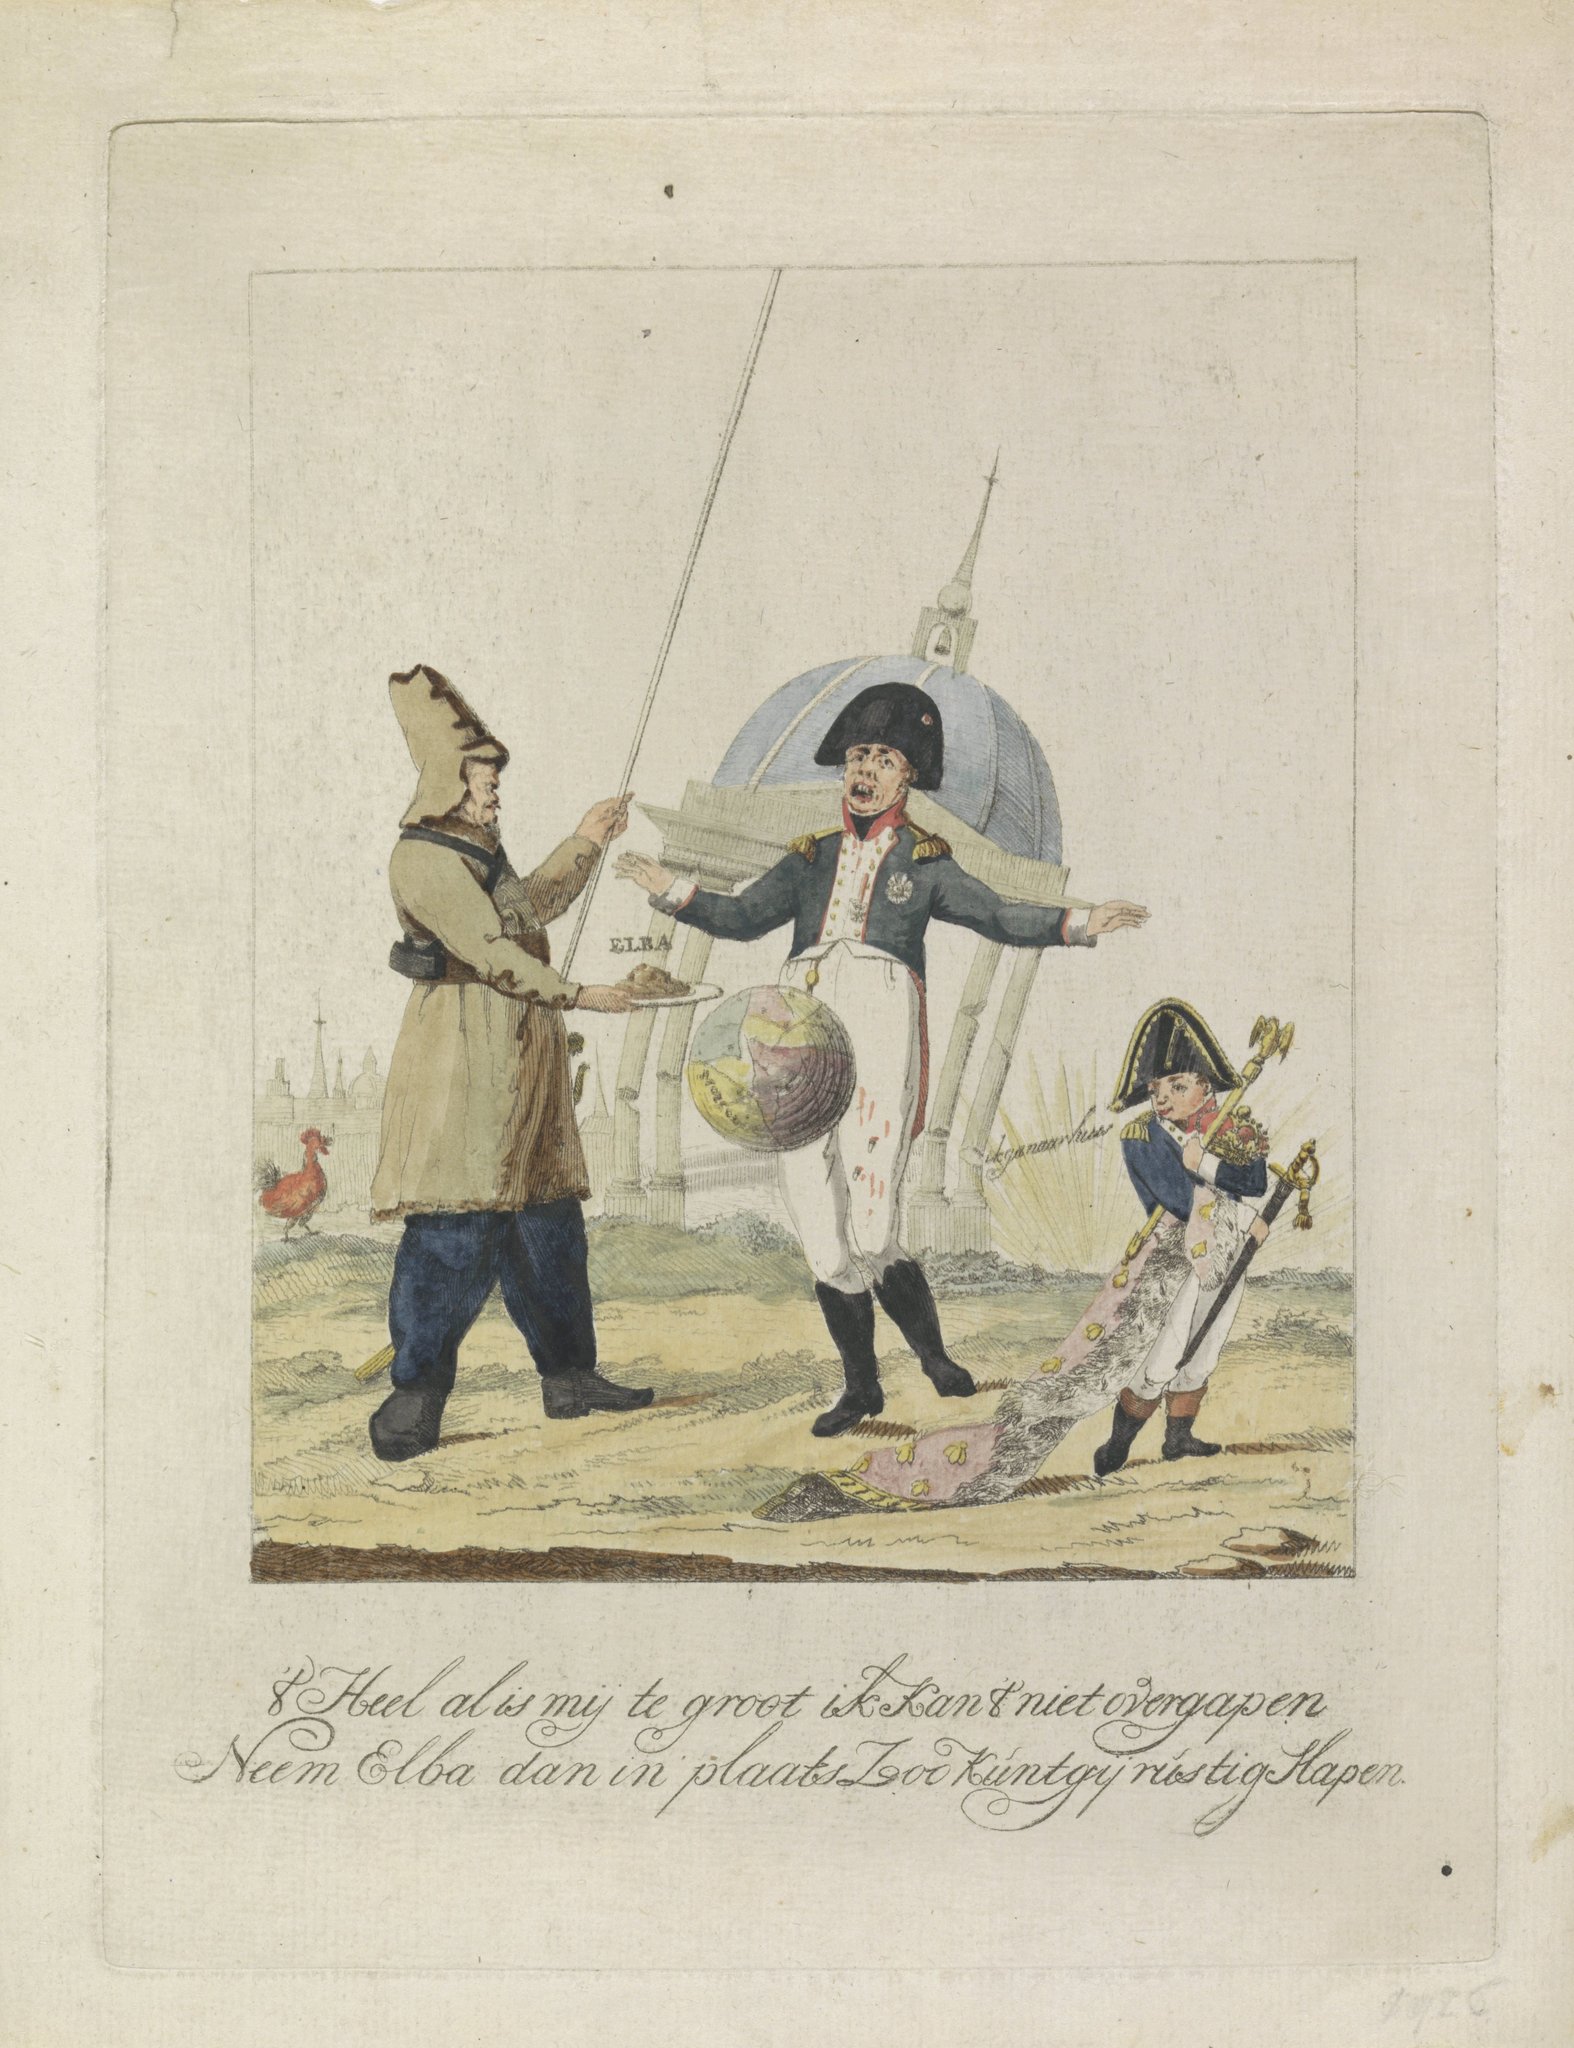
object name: cartoon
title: Napoleon krijgt Elba, 1814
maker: Anonymous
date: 1814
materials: paper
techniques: etching, hand coloring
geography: netherlands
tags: paris, vienna, napoleon i (emperor of the french), collapsing building, insignia and symbols of sovereignty (crown, diadem, sceptre, orb, seal, standard, cloak, pectoral)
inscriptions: collector's mark: Lugt 2228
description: Spotprent op Napoleons verbanning naar Elba, mei 1814. Een klagende Napoleon moet de wereldbol laten vallen en krijgt in plaats daarvan het eiland Elba, dat hem door een kozak op een bordje wordt aangereikt. Rechts vertrekt de koning van Rome, de zoon van Napoleon, met keizerskroon, scepter, zwaard en mantel. Op de achtergrond een instortende tempel, mogelijk de koepel van het Hôtel des Invalides in Parijs. Met tweeregelig onderschrift.